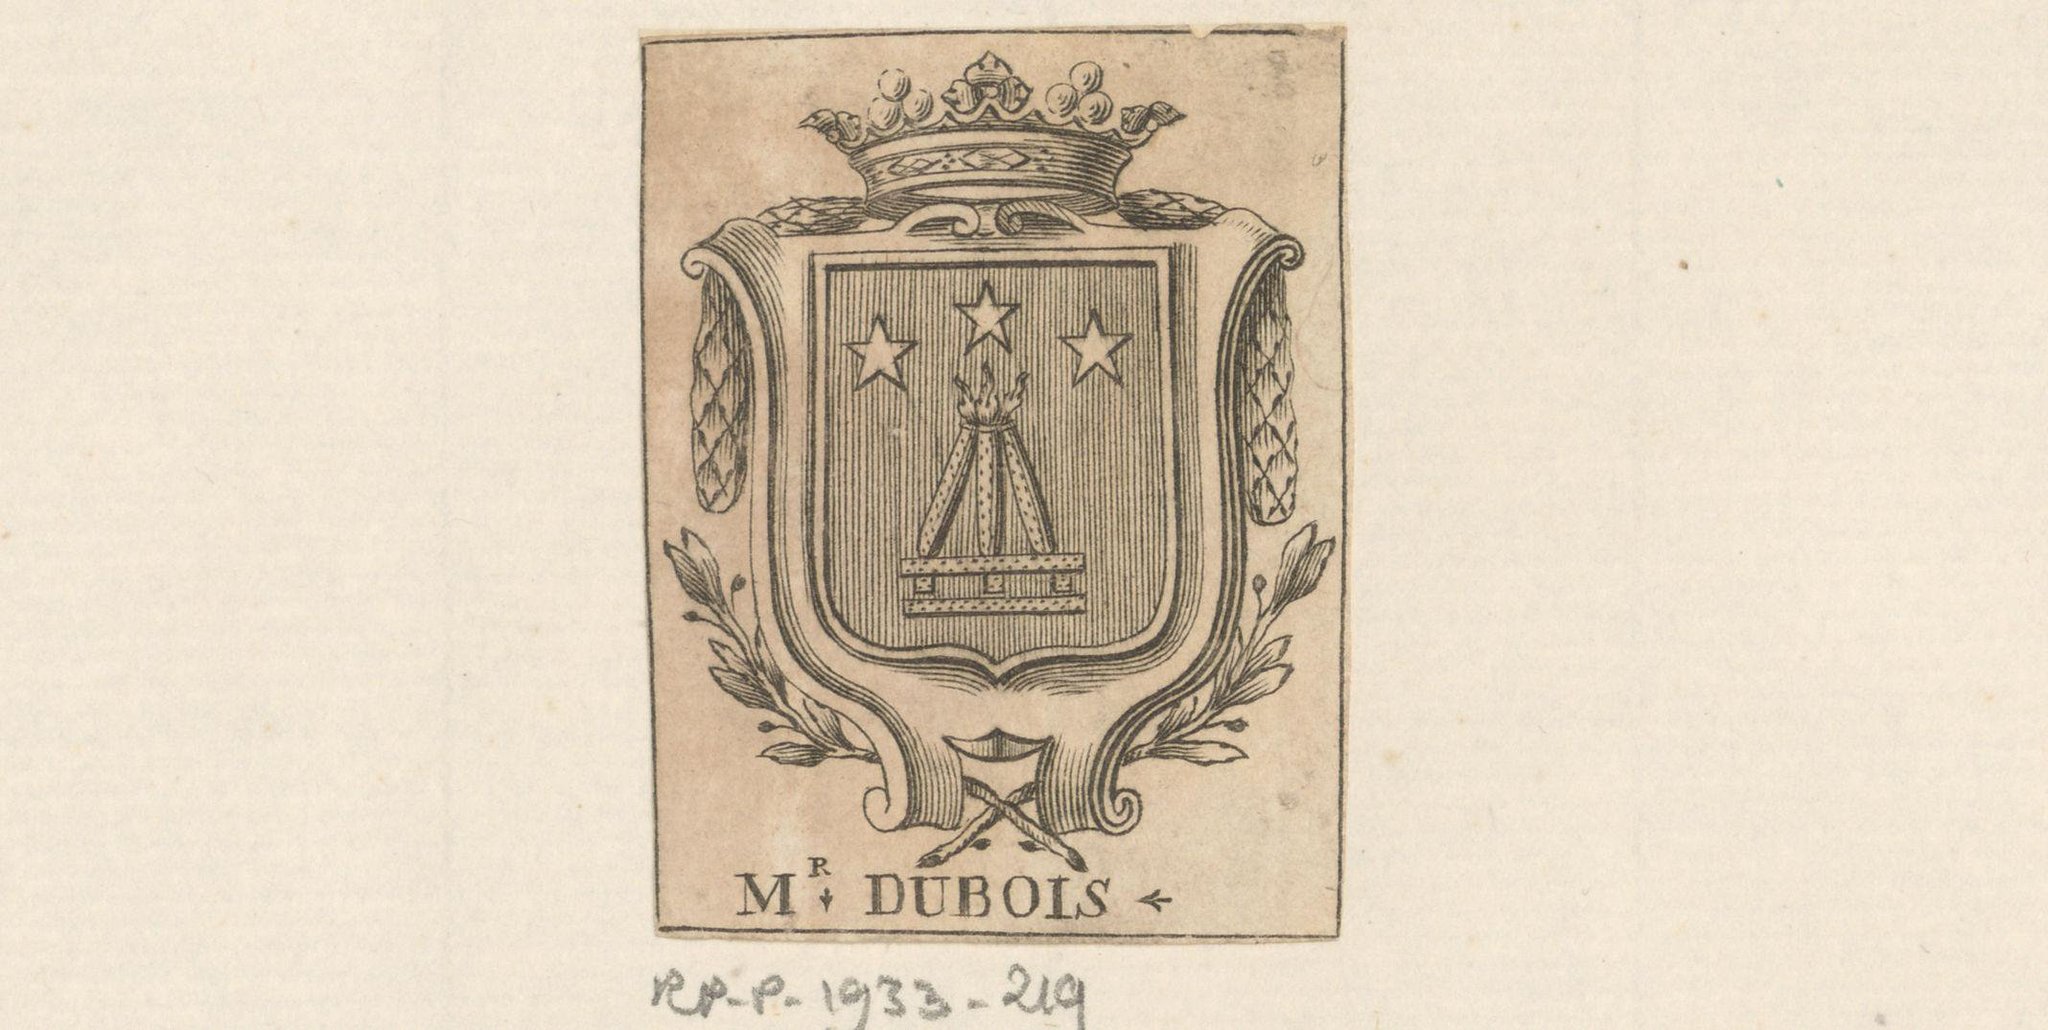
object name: bookplate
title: Ex libris van Mr. Dubois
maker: Anonymous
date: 1700-1849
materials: paper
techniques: engraving, etching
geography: france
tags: stars, armorial bearing, heraldry